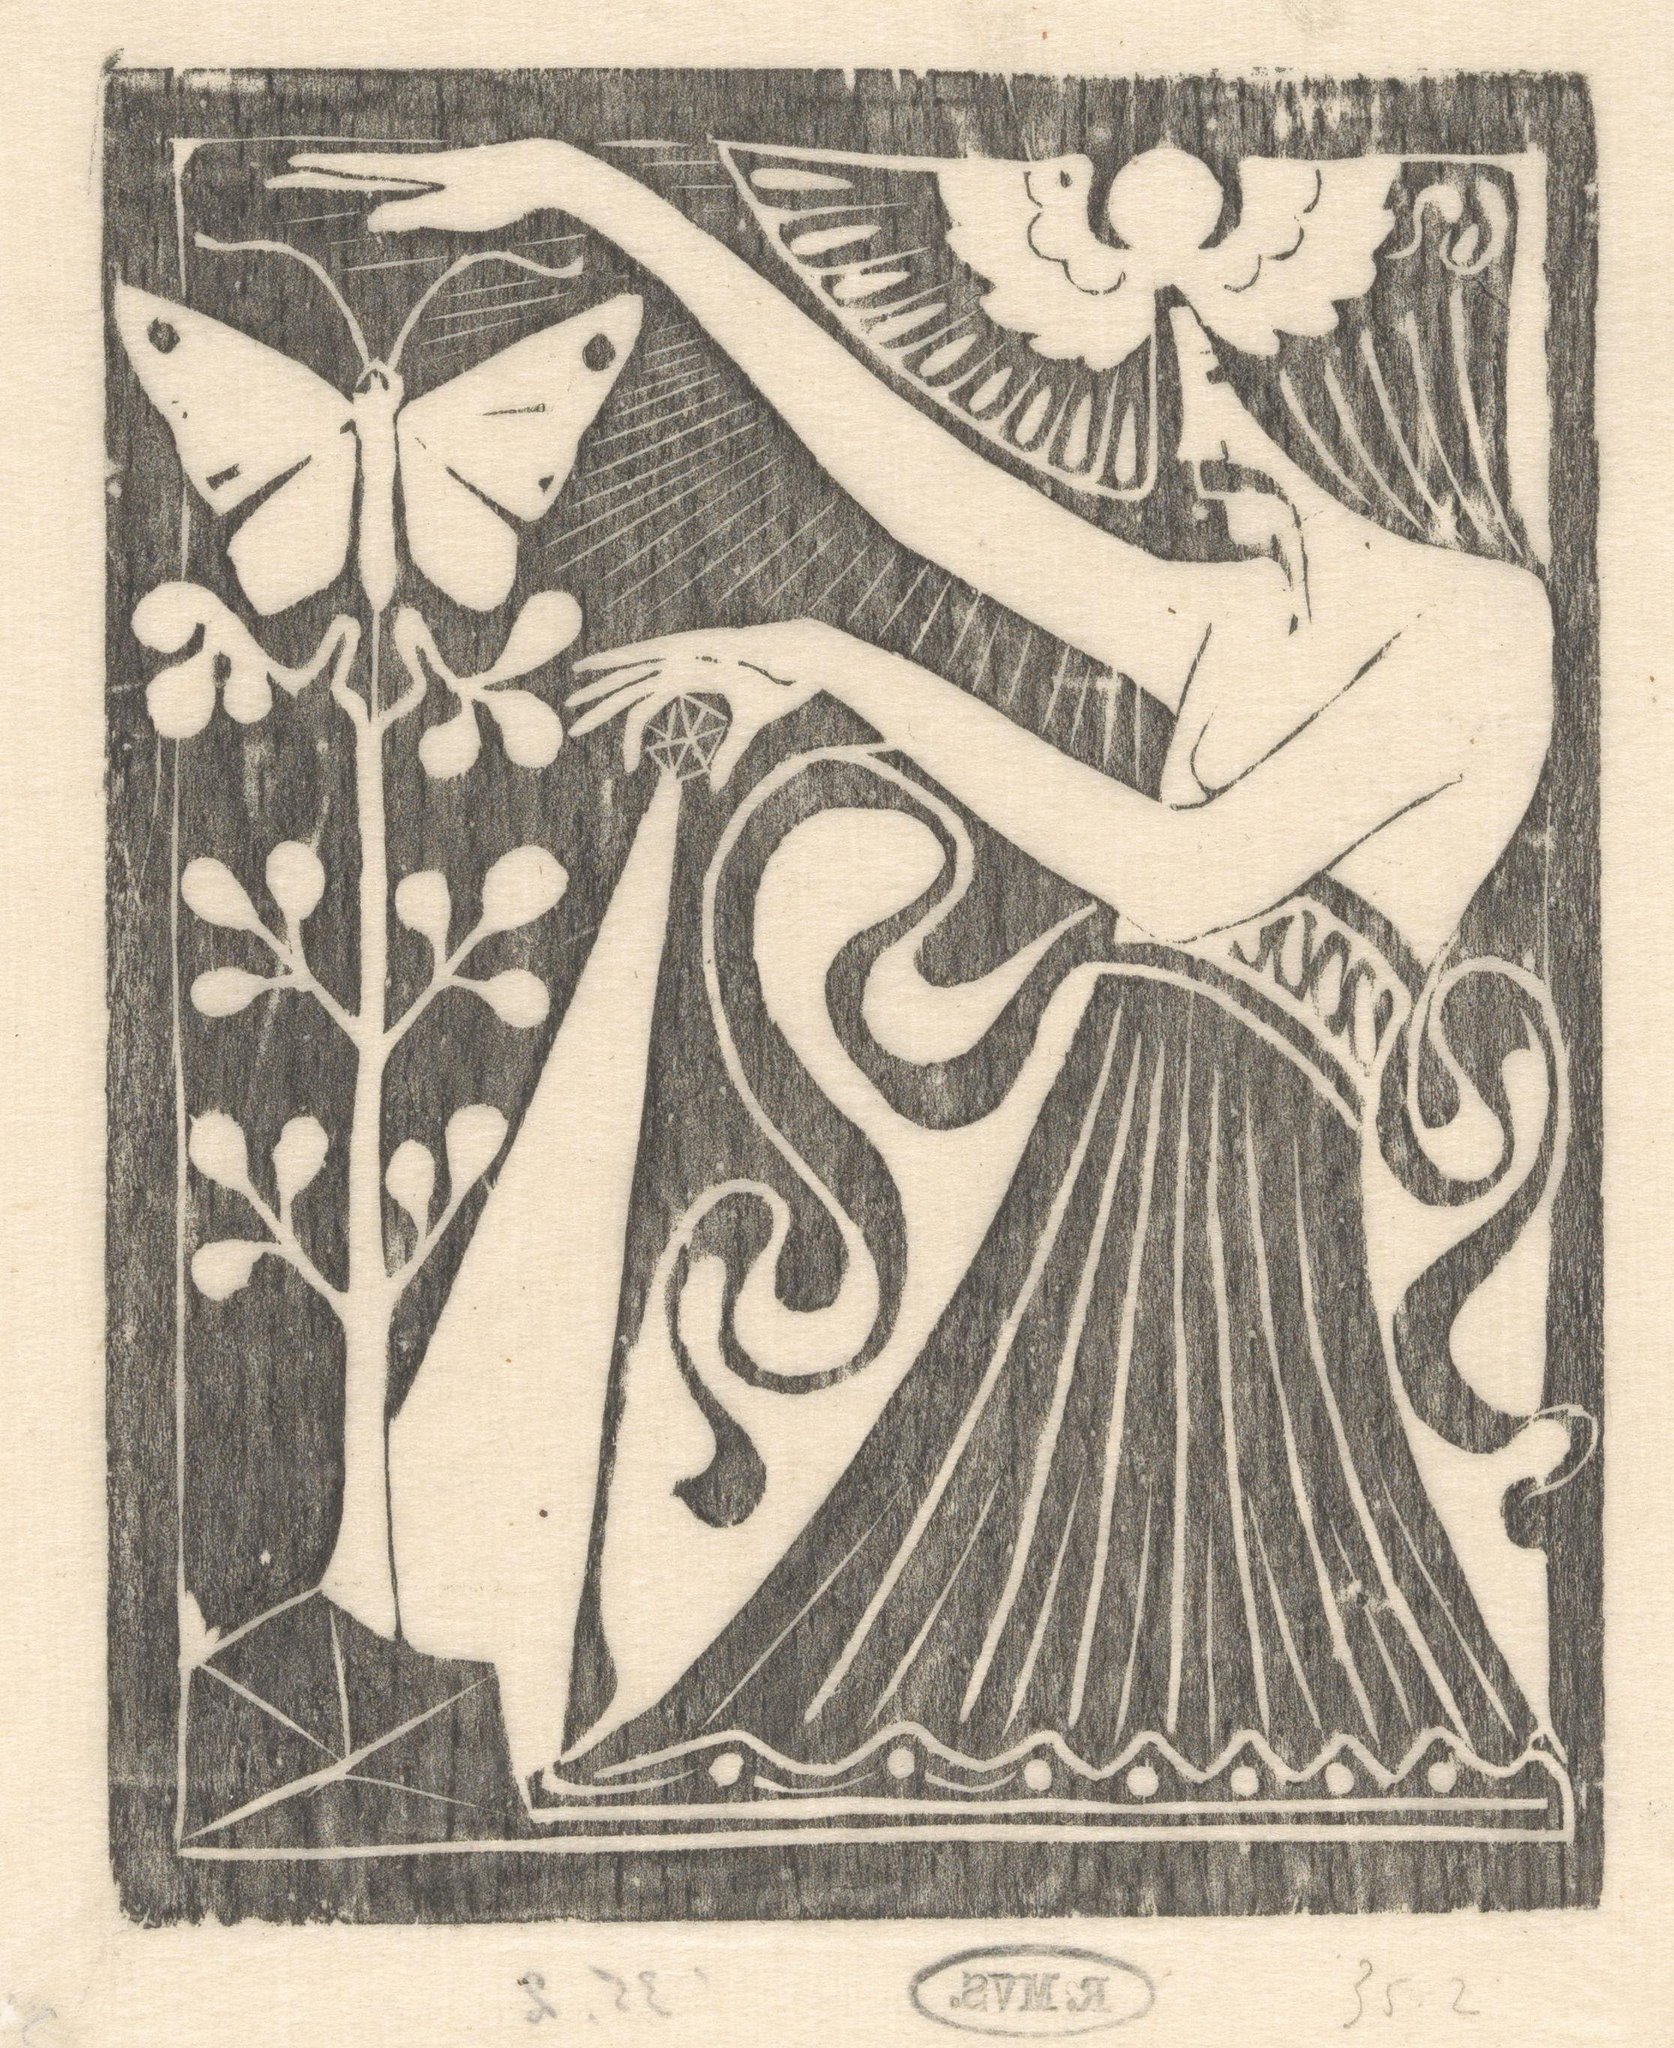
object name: print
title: Vrouw met een kristal bij een vlinder en een plant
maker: karel petrus cornelis de bazel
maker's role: draughtsman, print maker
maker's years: 1869-1923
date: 1894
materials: paper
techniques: woodcut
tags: plants; vegetation, crystals, evolution, woman (showing herself) undressed, quasi-nude, insects: butterfly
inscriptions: collector's mark: Lugt 2228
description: Rechts een staande vrouw met ontbloot bovenlijf, in profiel weergegeven. Ze houdt haar linkerhand boven een vlinder en een plant, in haar rechterhand houdt ze een kristal vast waar een lichtbundel doorheen valt.